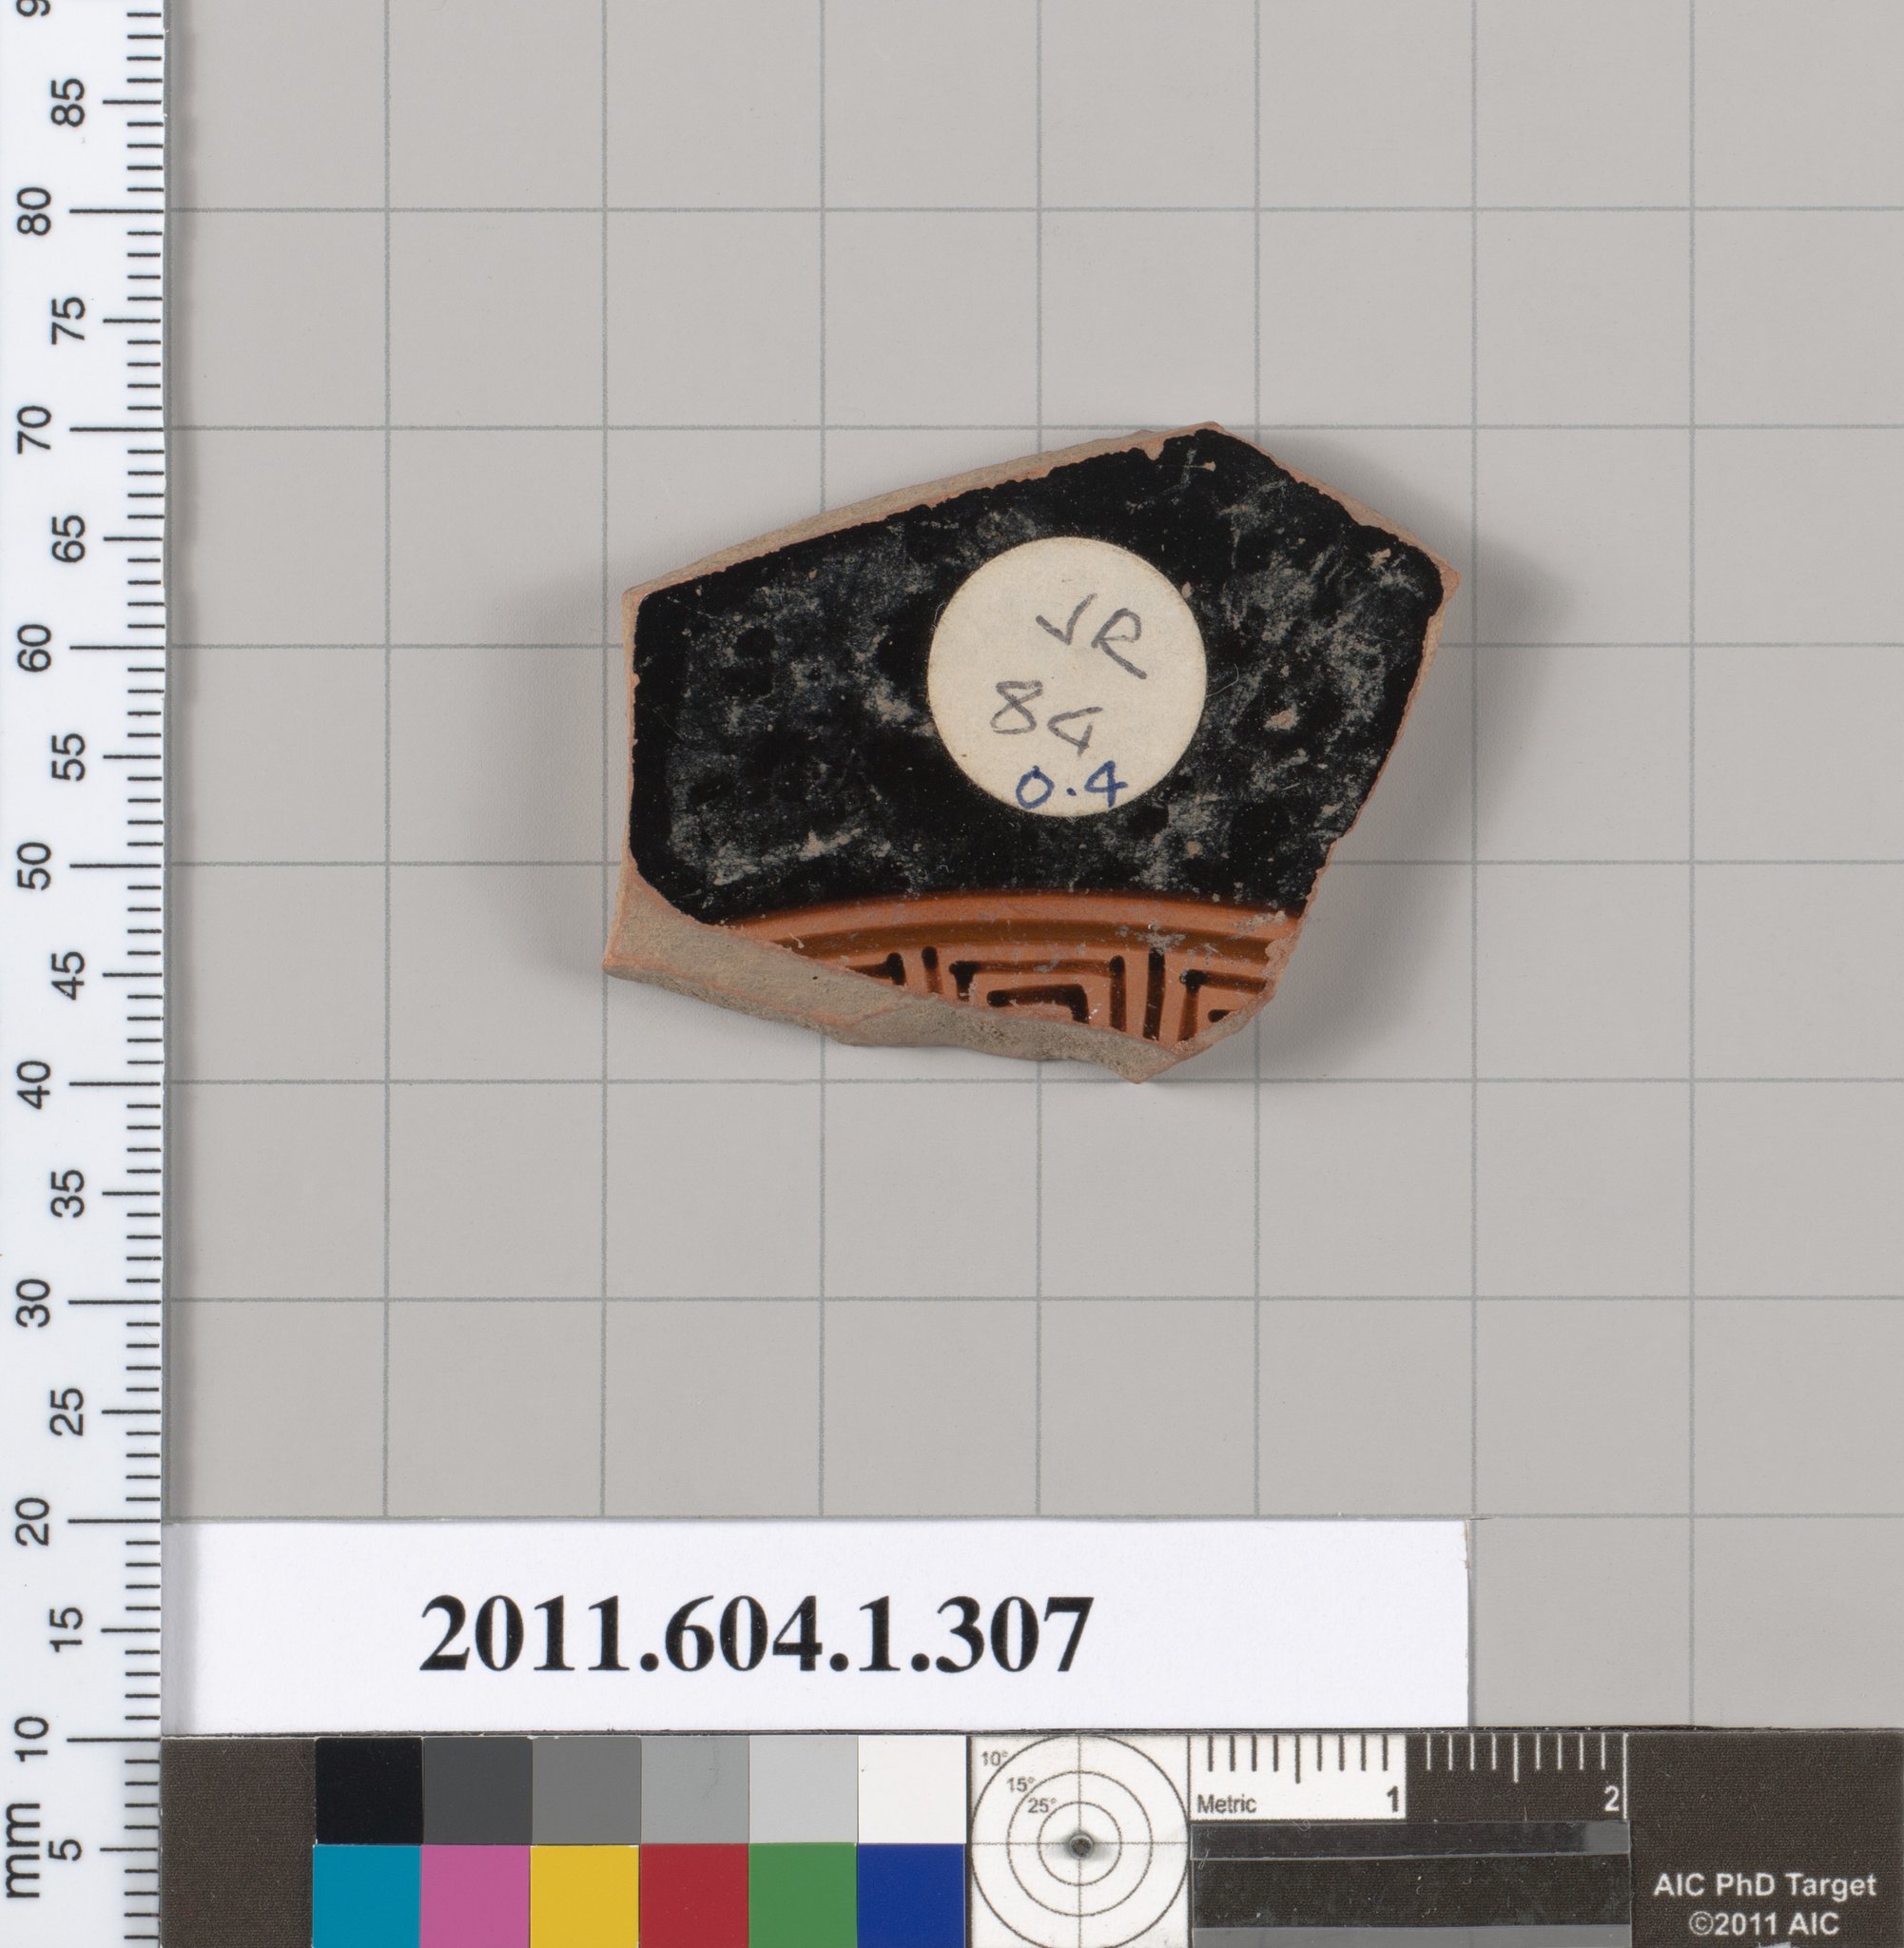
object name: kylix fragment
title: Terracotta fragment of a kylix (drinking cup)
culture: greek, attic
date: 475-451 BCE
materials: terracotta